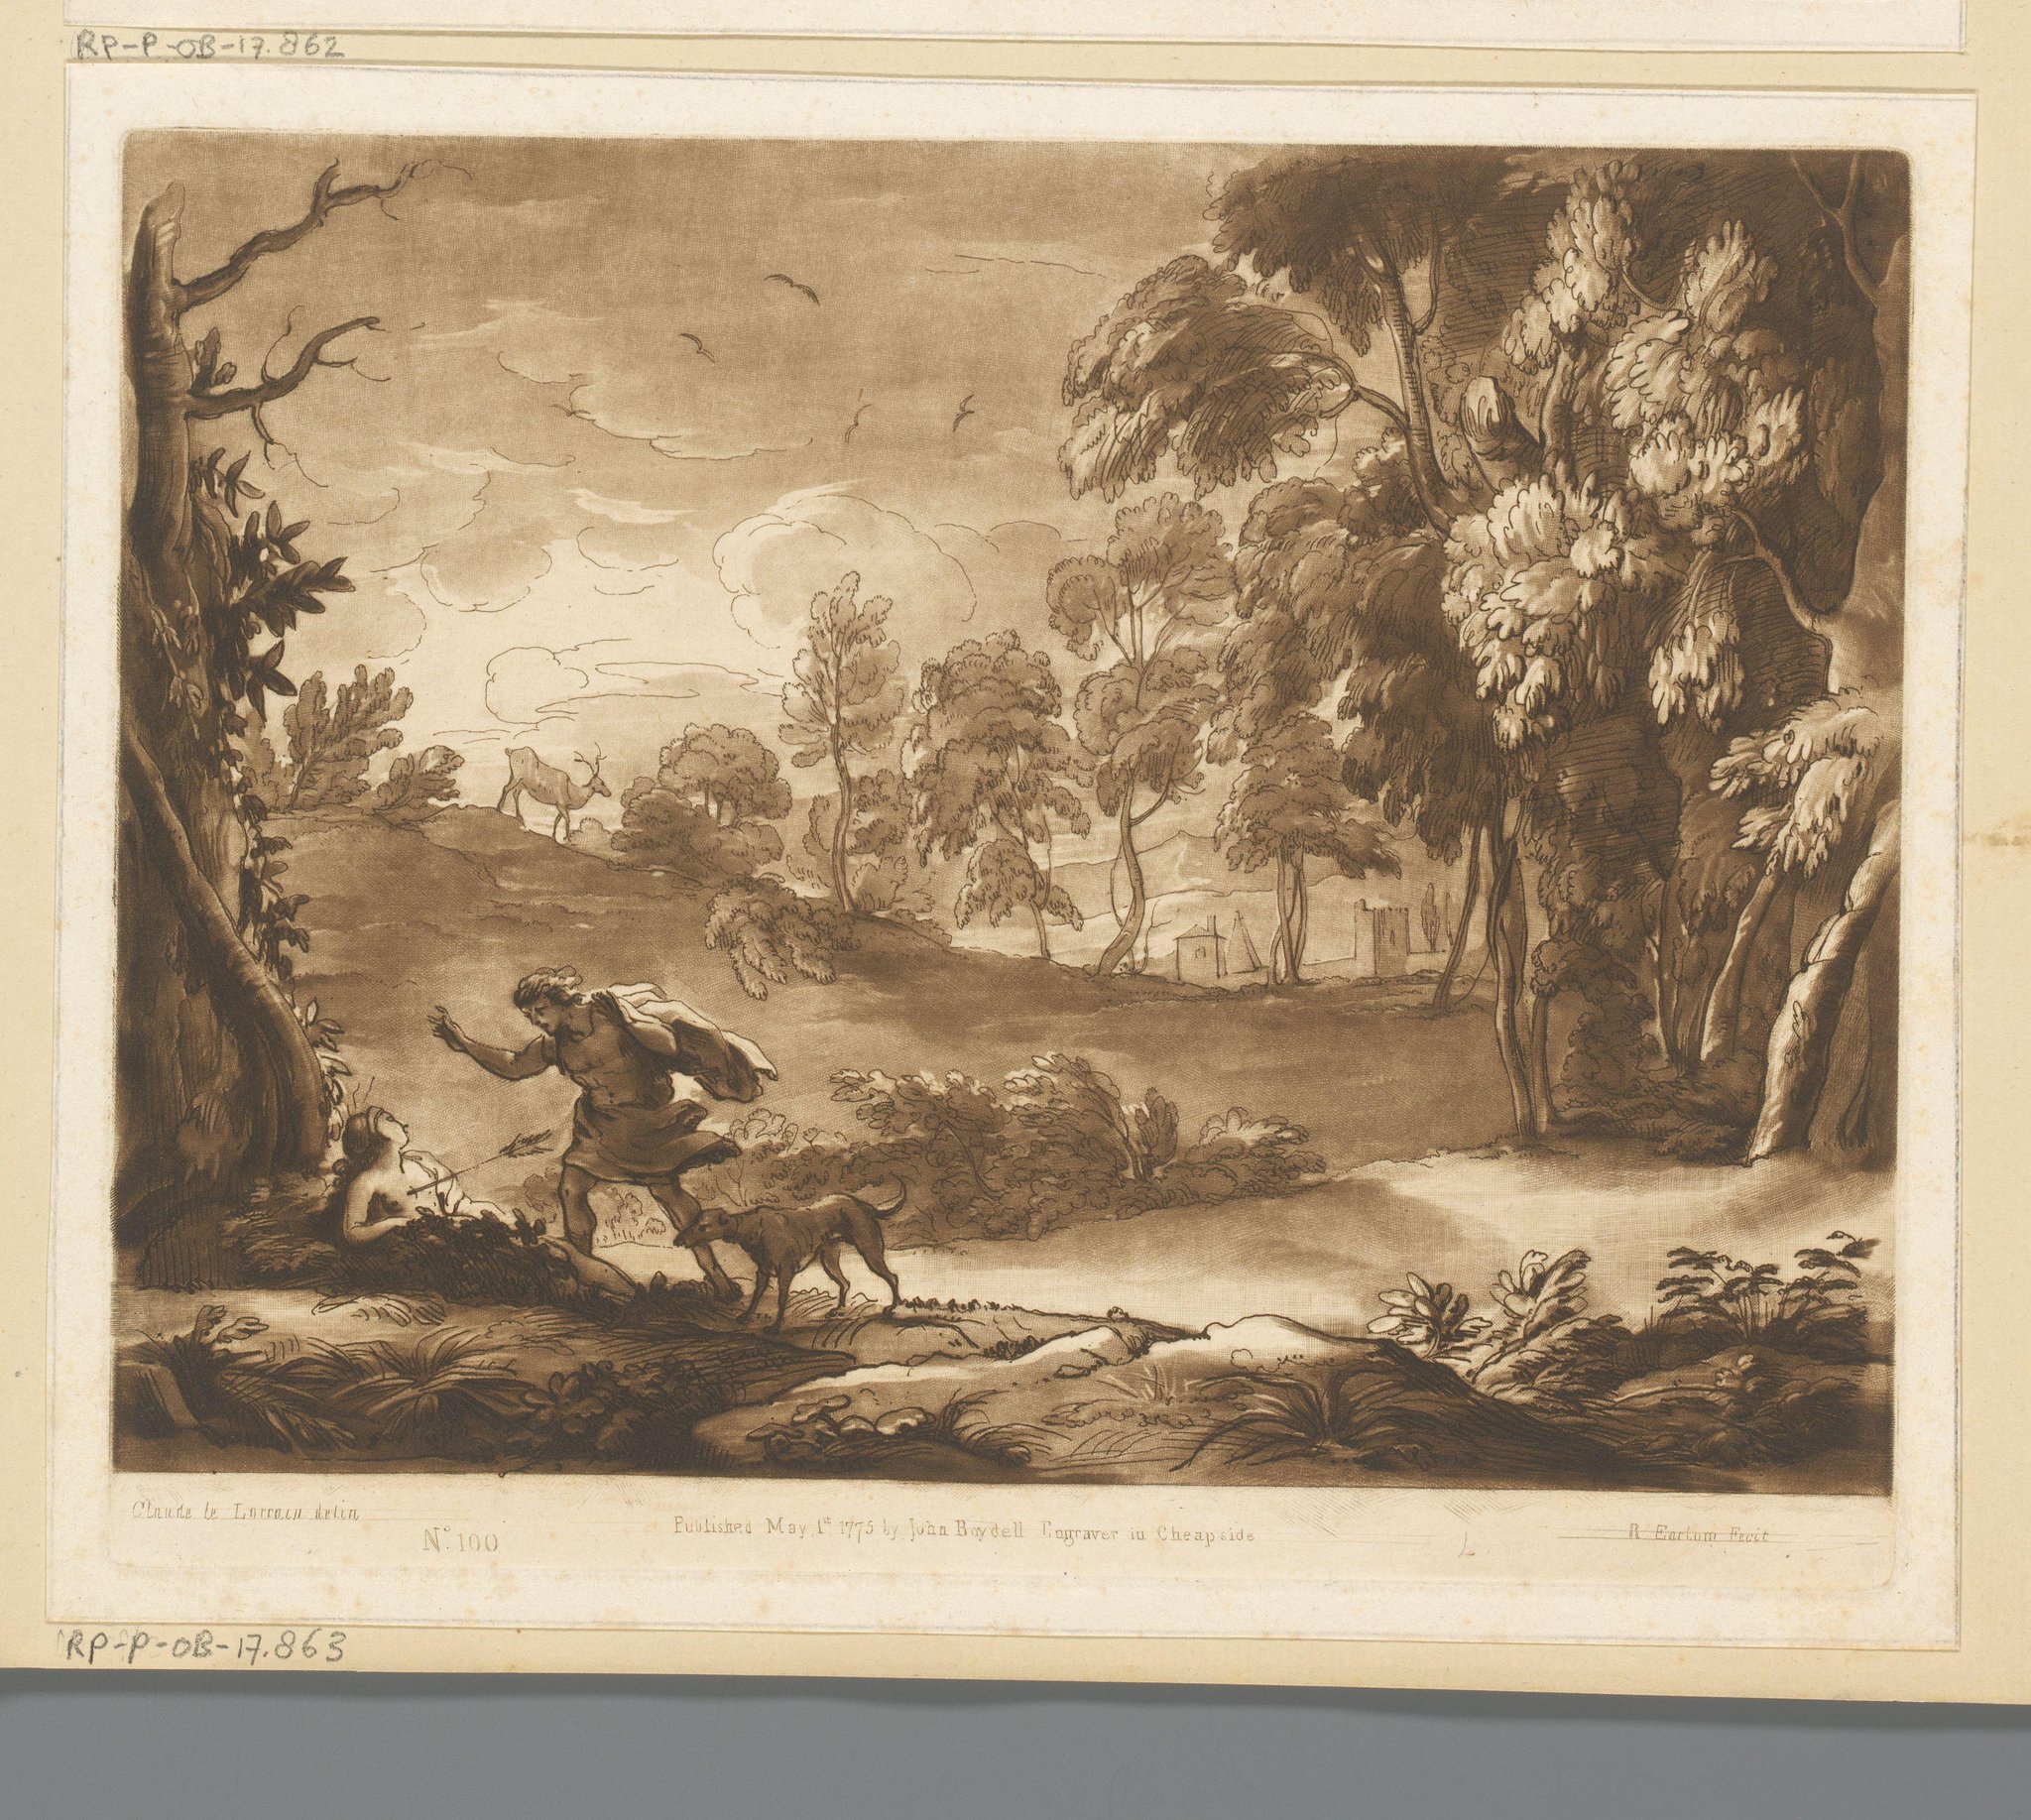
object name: print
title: Prenten naar tekeningen van Claude Lorrain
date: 1775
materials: paper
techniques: etching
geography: london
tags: forest, wood - hh - ideal landscapes, cephalus inadvertently kills procris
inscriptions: date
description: Vanaf 1774 publiceerde John Boydell tweehonderd prenten naar het tekeningenboek Liber Veritatis van Claude Lorrain, in het bezit van de hertogen van Cavendish. Deze prenten werden vanaf 1777 in twee volumes gebundeld uitgegeven.